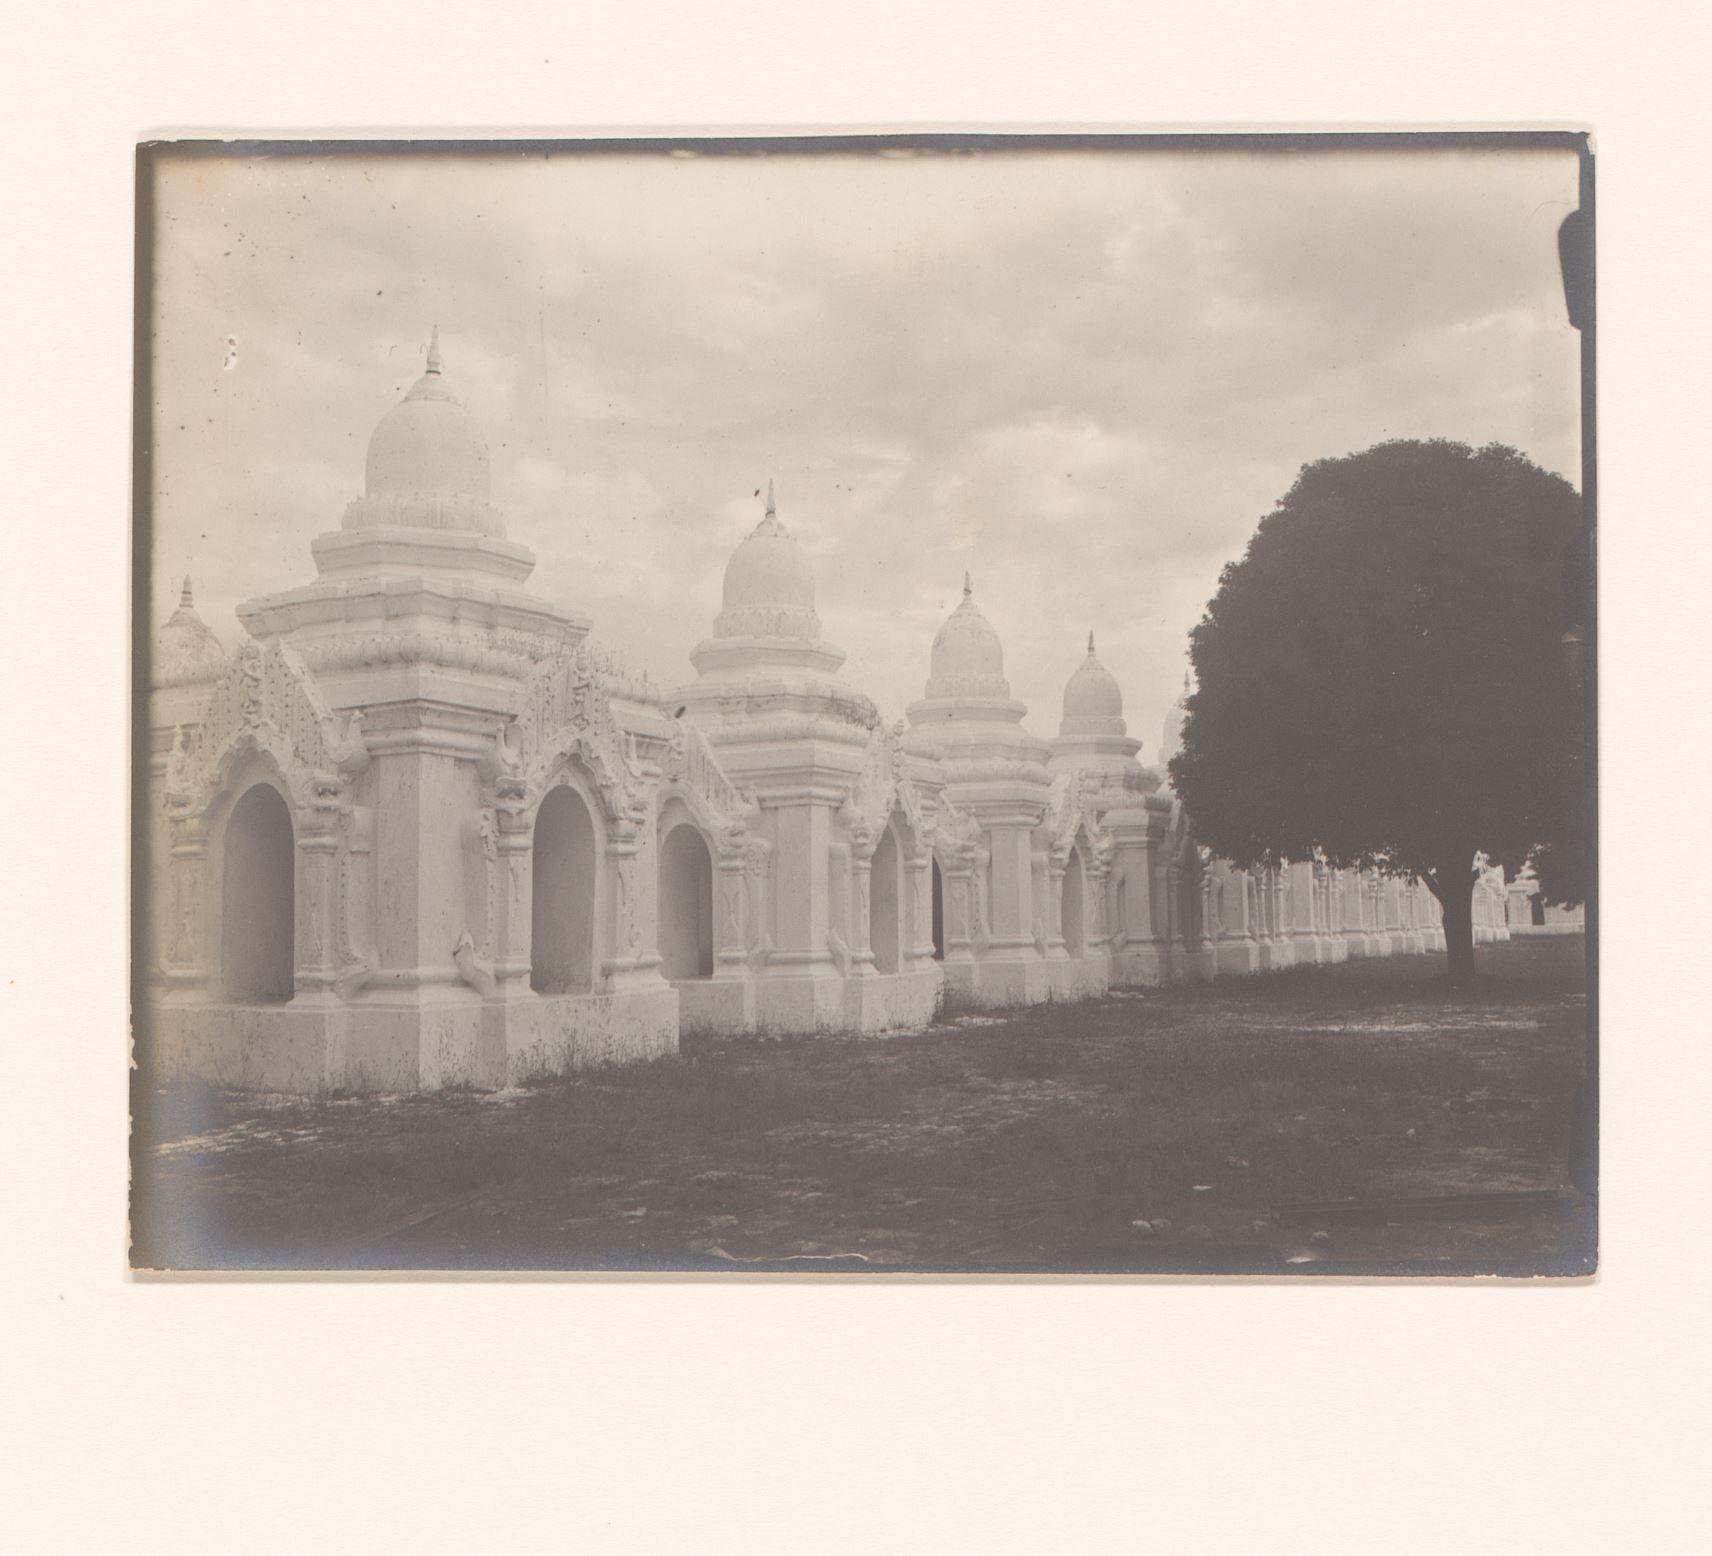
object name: photograph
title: Row of Buddhist shrines and a tree, Myanmar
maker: jan adriani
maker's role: fotograaf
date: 1907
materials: photographic support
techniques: gelatin silver print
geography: myanmar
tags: places and objects of worship ~ hinduism, buddhism, jainism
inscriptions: inscription: ‘54/ AG 72’